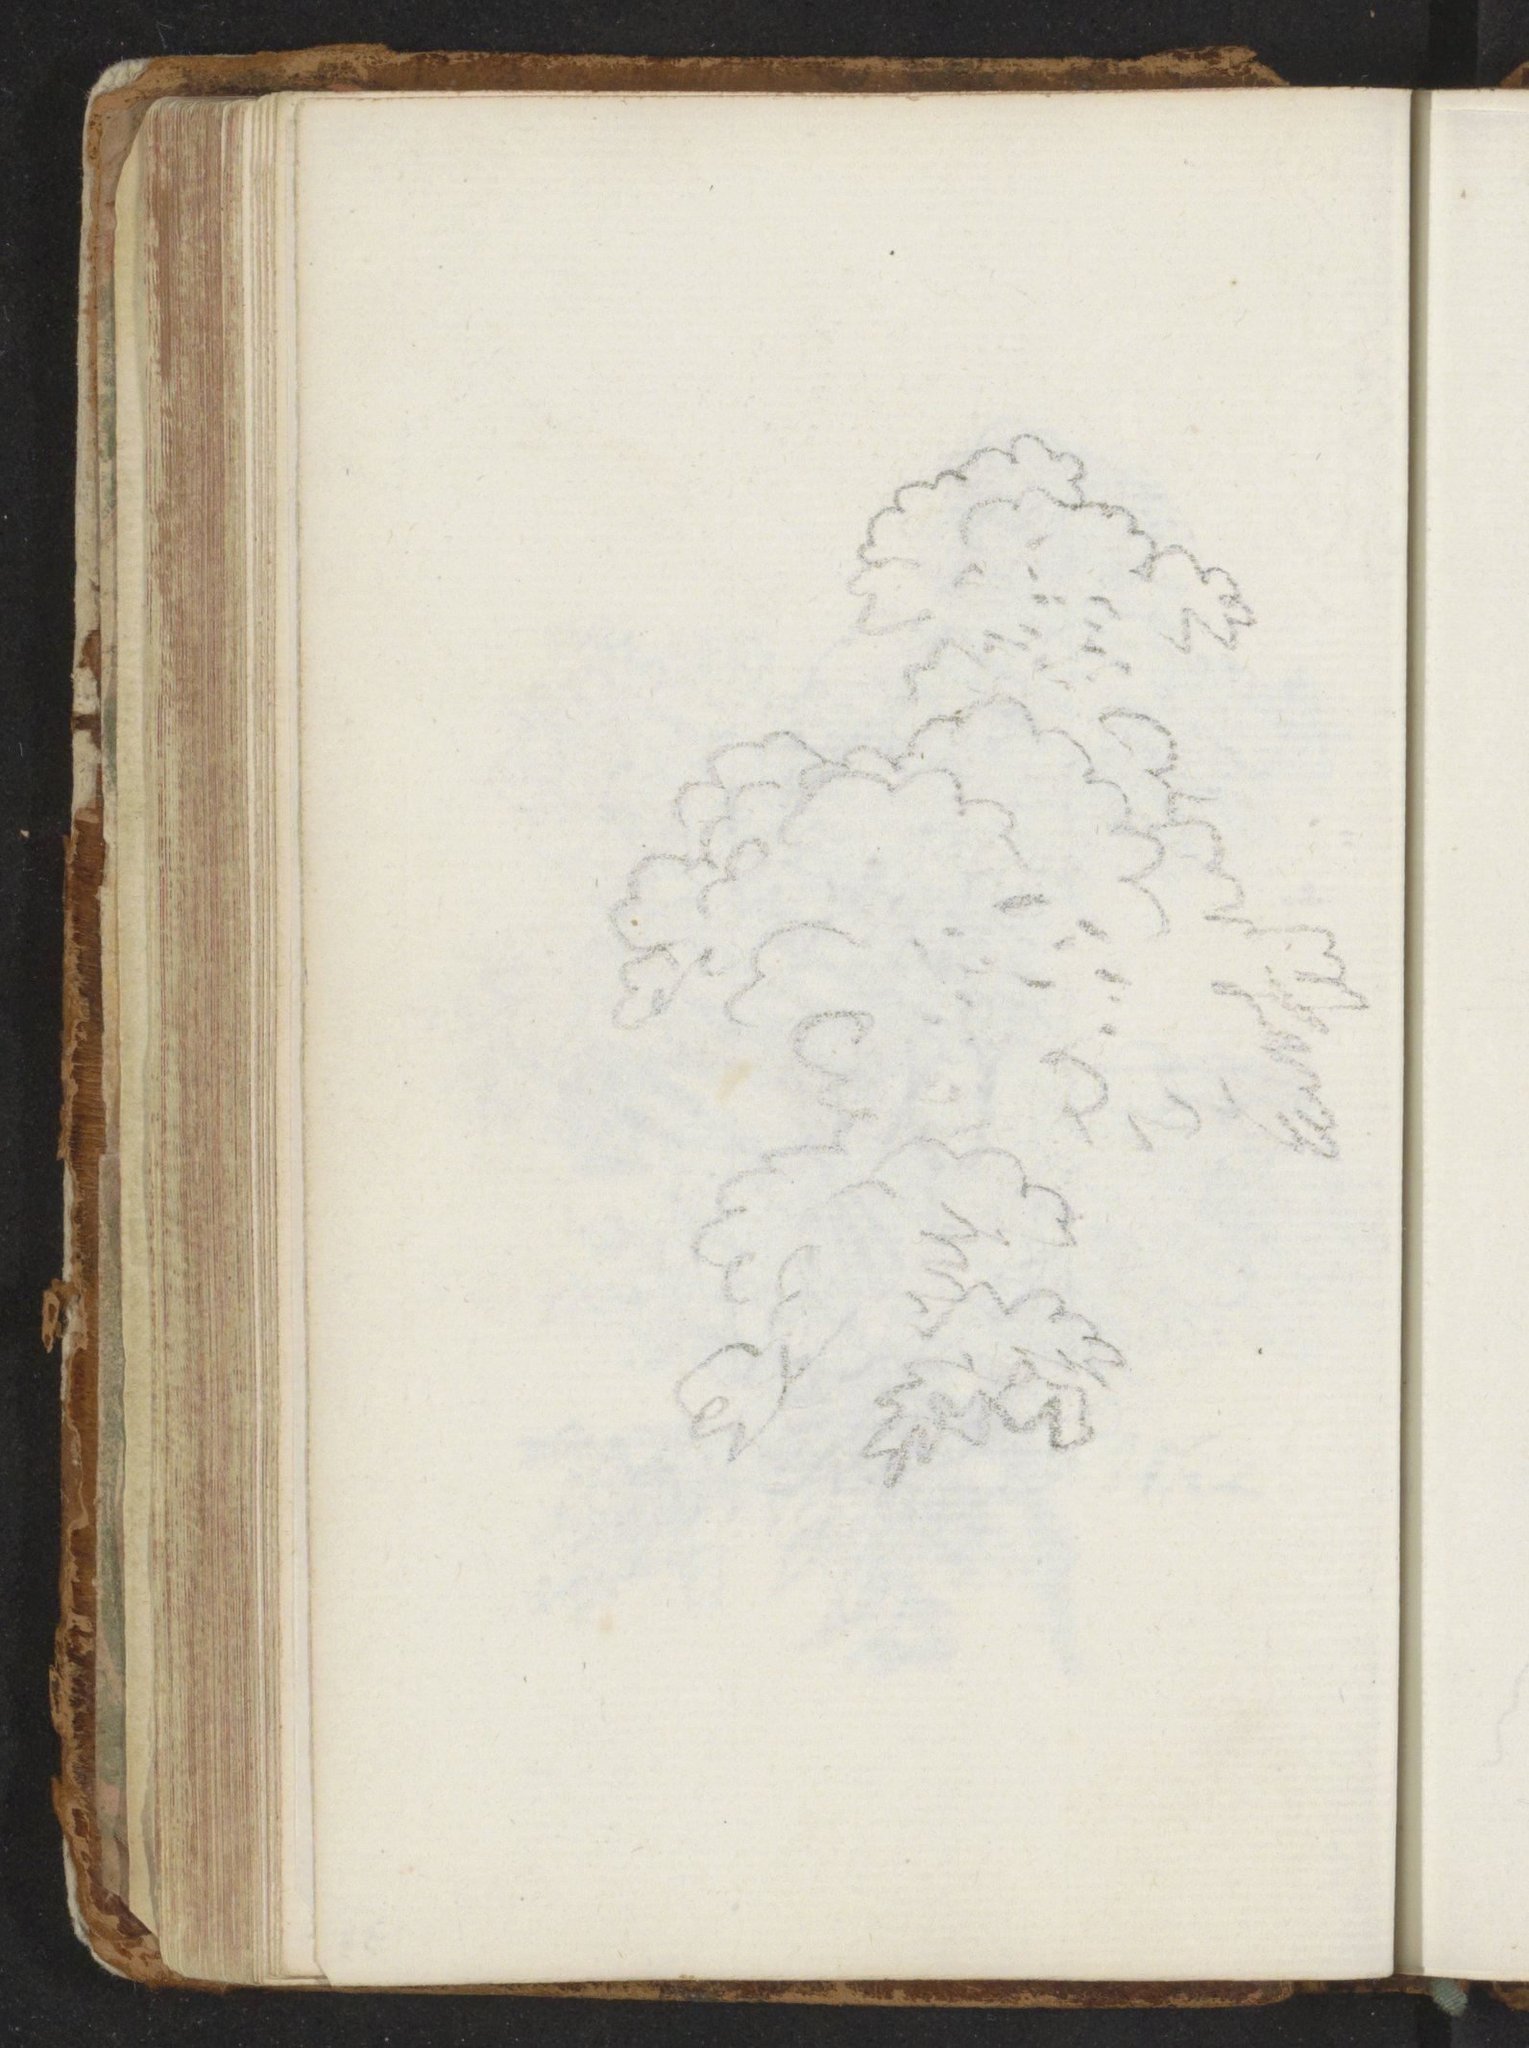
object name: sketchbook leaf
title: Bladerdek van een boom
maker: jean honoré fragonard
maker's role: draughtsman, painter, print maker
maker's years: 1732-1806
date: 1765-1775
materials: chalk, paper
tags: trees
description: Blad 40 verso uit een schetsboek met 83 bladen.